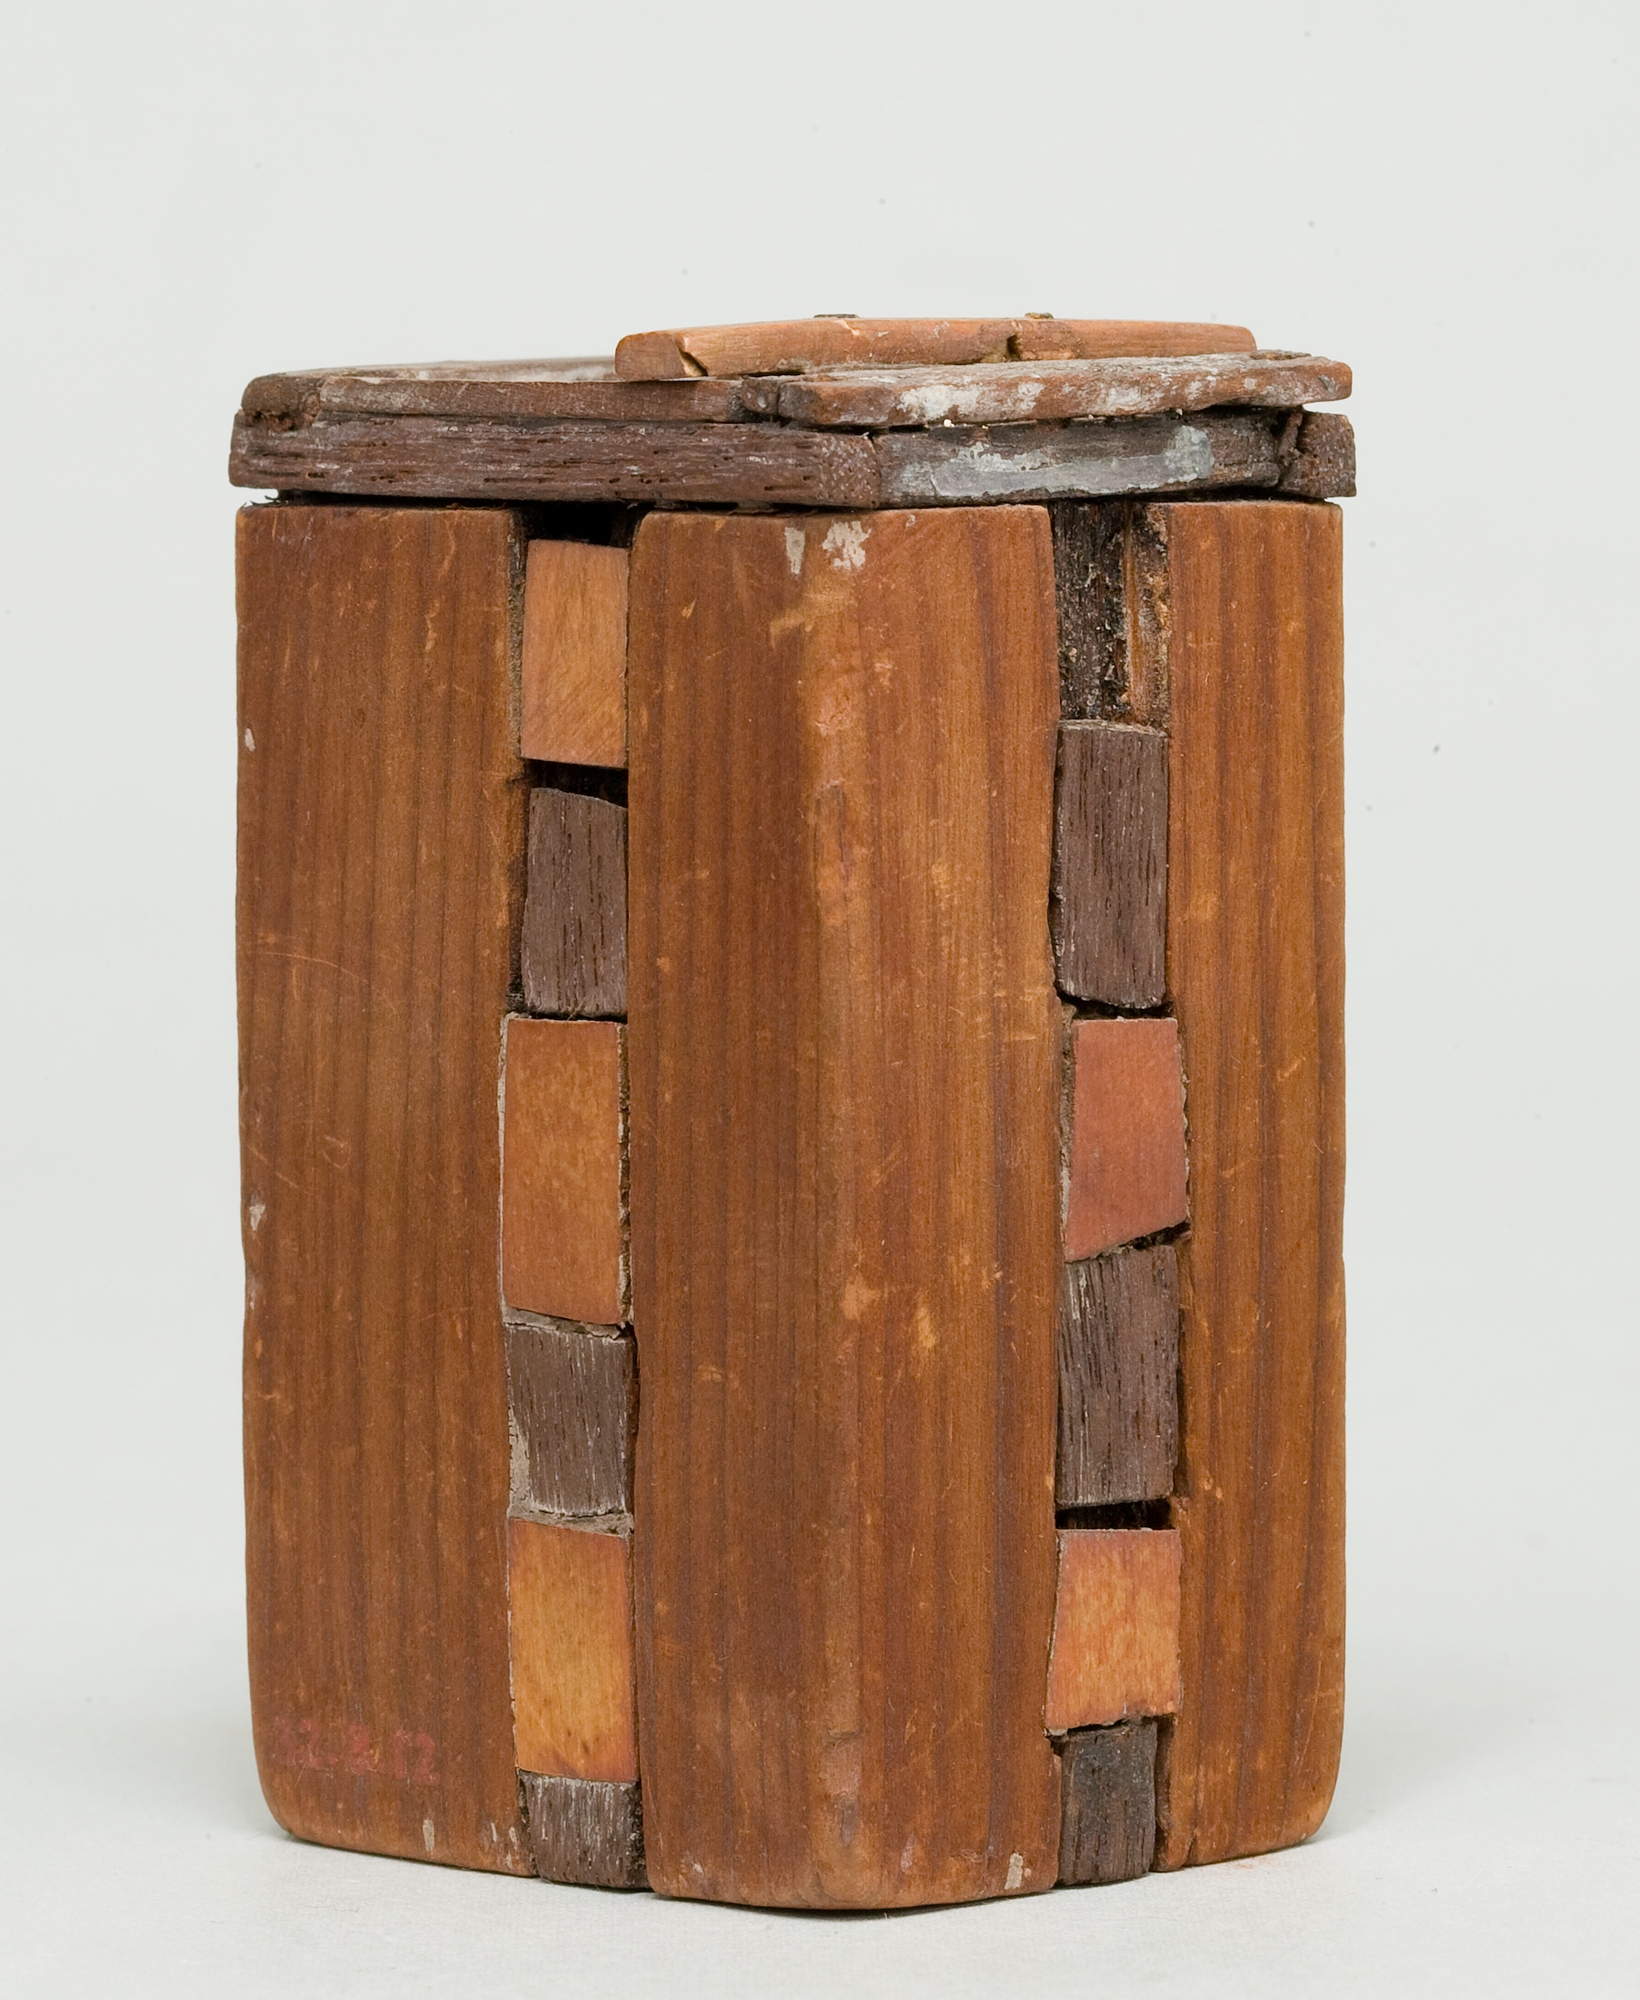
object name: box, compartmented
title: Box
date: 1295-1070 BCE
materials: wood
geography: egypt